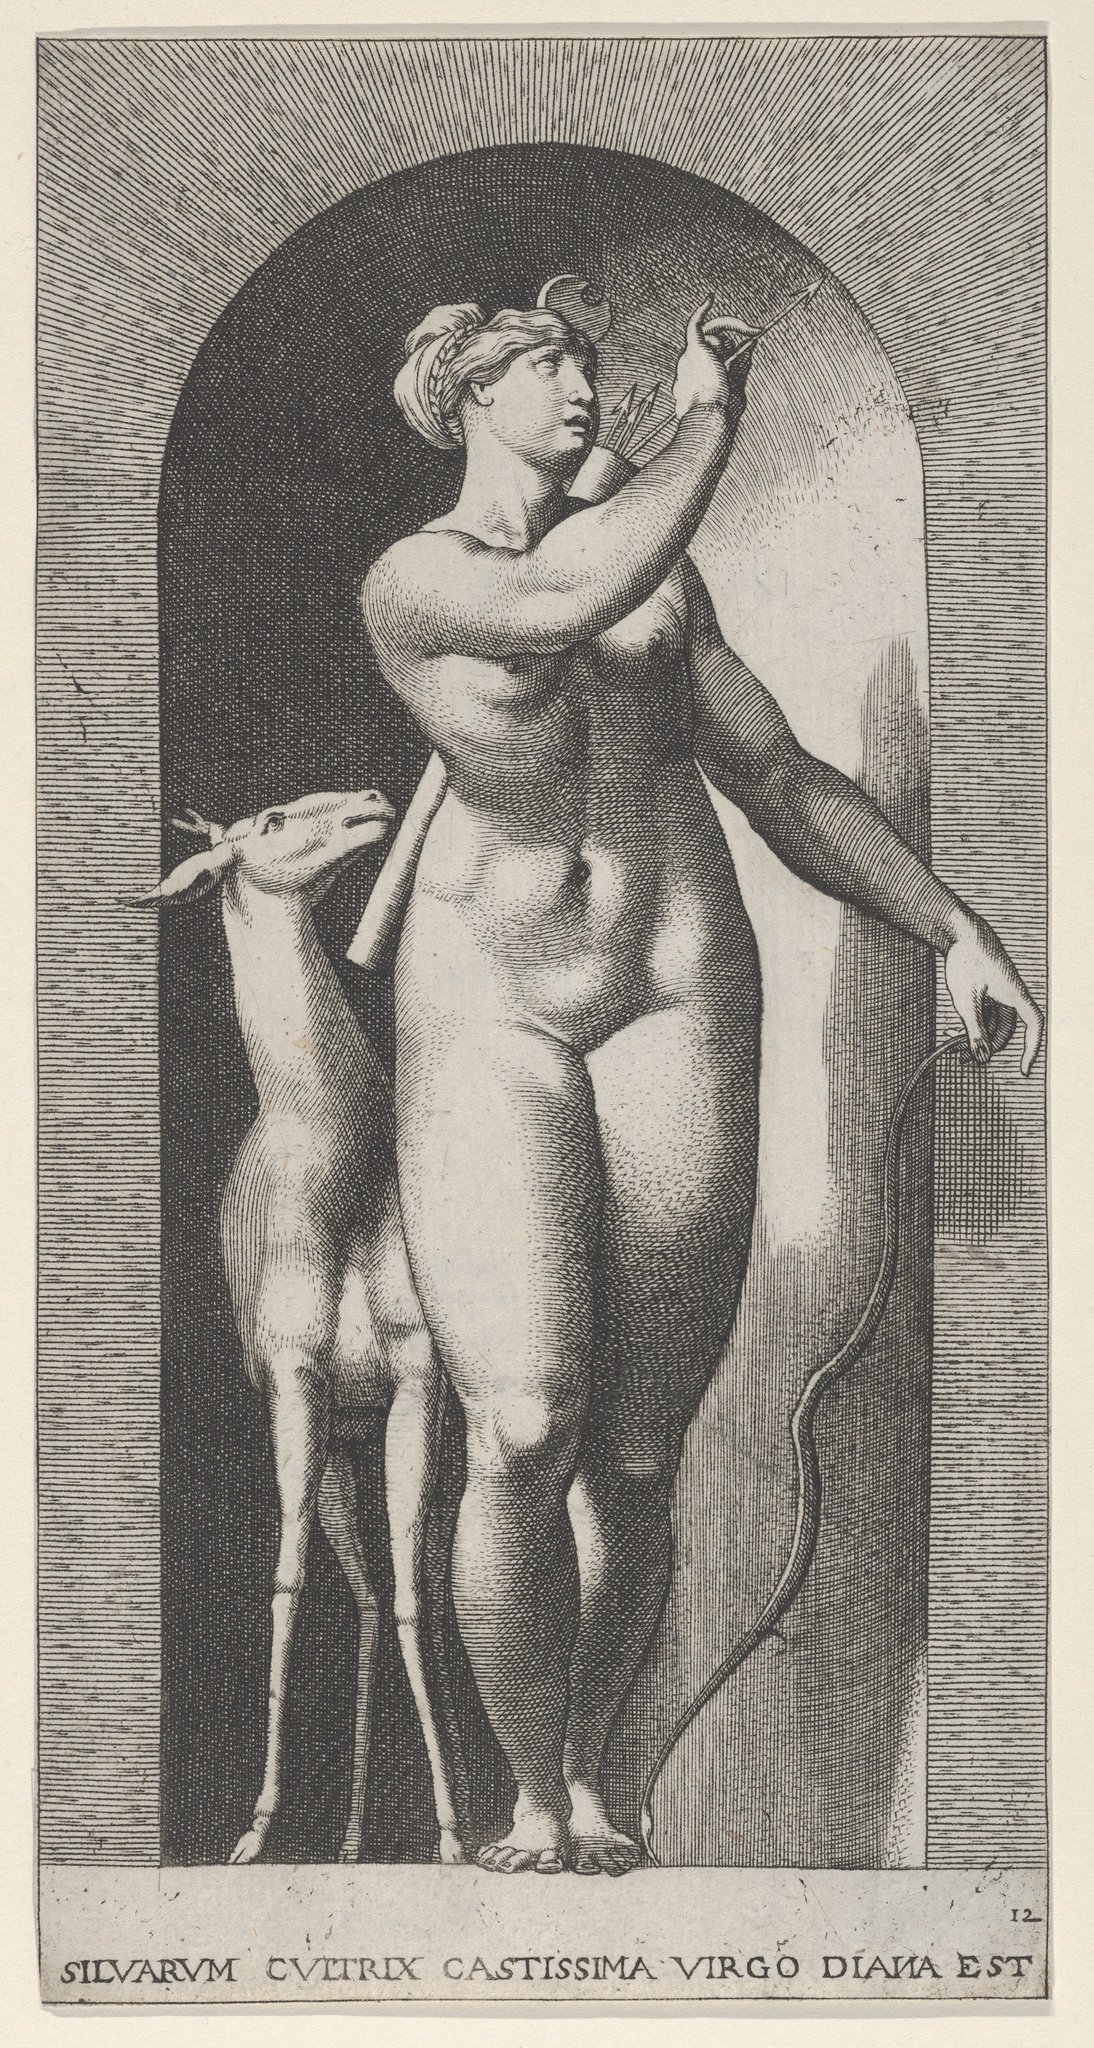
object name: print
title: Plate 12: Diana standing in a niche, twisting to her left and pulling an arrow out of a quiver, with a deer to her right, from "Mythological Gods and Goddesses"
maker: giovanni jacopo caraglio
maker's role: artist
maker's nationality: italian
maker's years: 1500-1565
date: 1526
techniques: engraving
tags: bow and arrow,female nudes,diana,deer